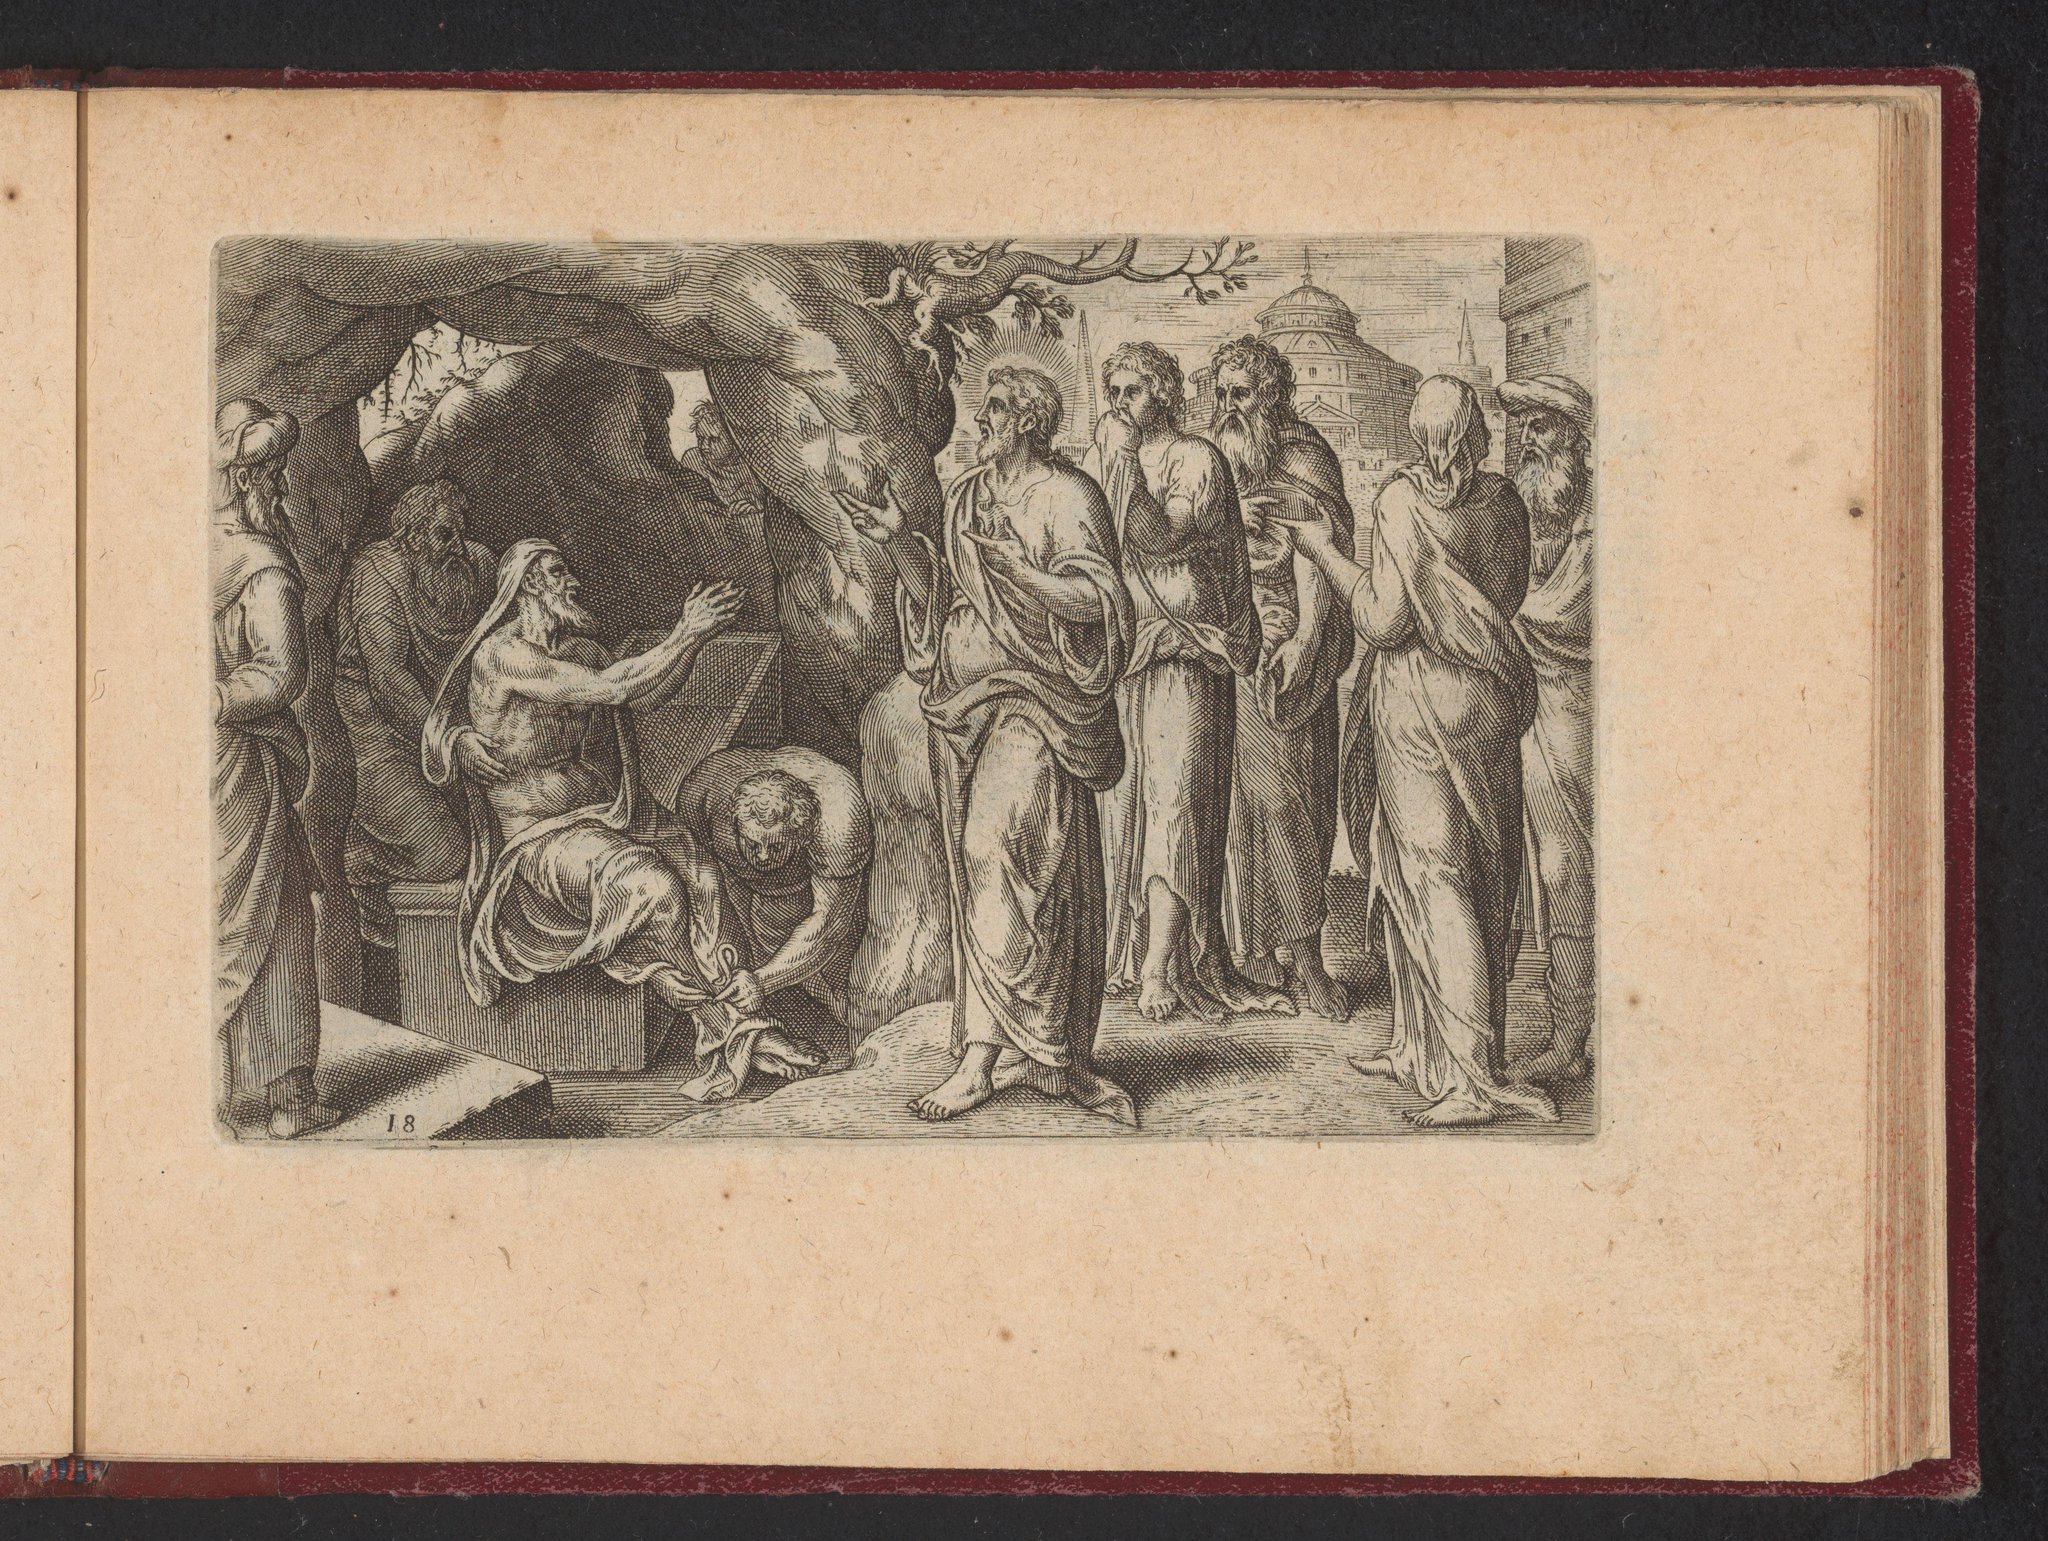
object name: print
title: Opwekking van Lazarus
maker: philips galle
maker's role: print maker, publisher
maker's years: 1537-1612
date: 1573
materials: paper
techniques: engraving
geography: antwerp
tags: the raising of lazarus ('lazarus, come out')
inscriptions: watermark: ‘gotische letter P’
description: Onderdeel van een album met een titelprent en een serie van 50 prenten betreffende het leven en de passie van Christus.